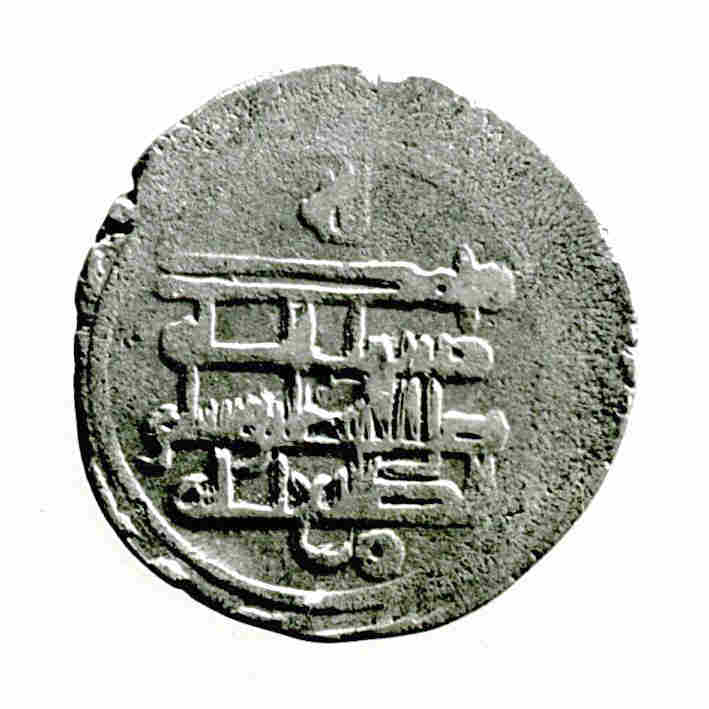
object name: coin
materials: silver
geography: iran